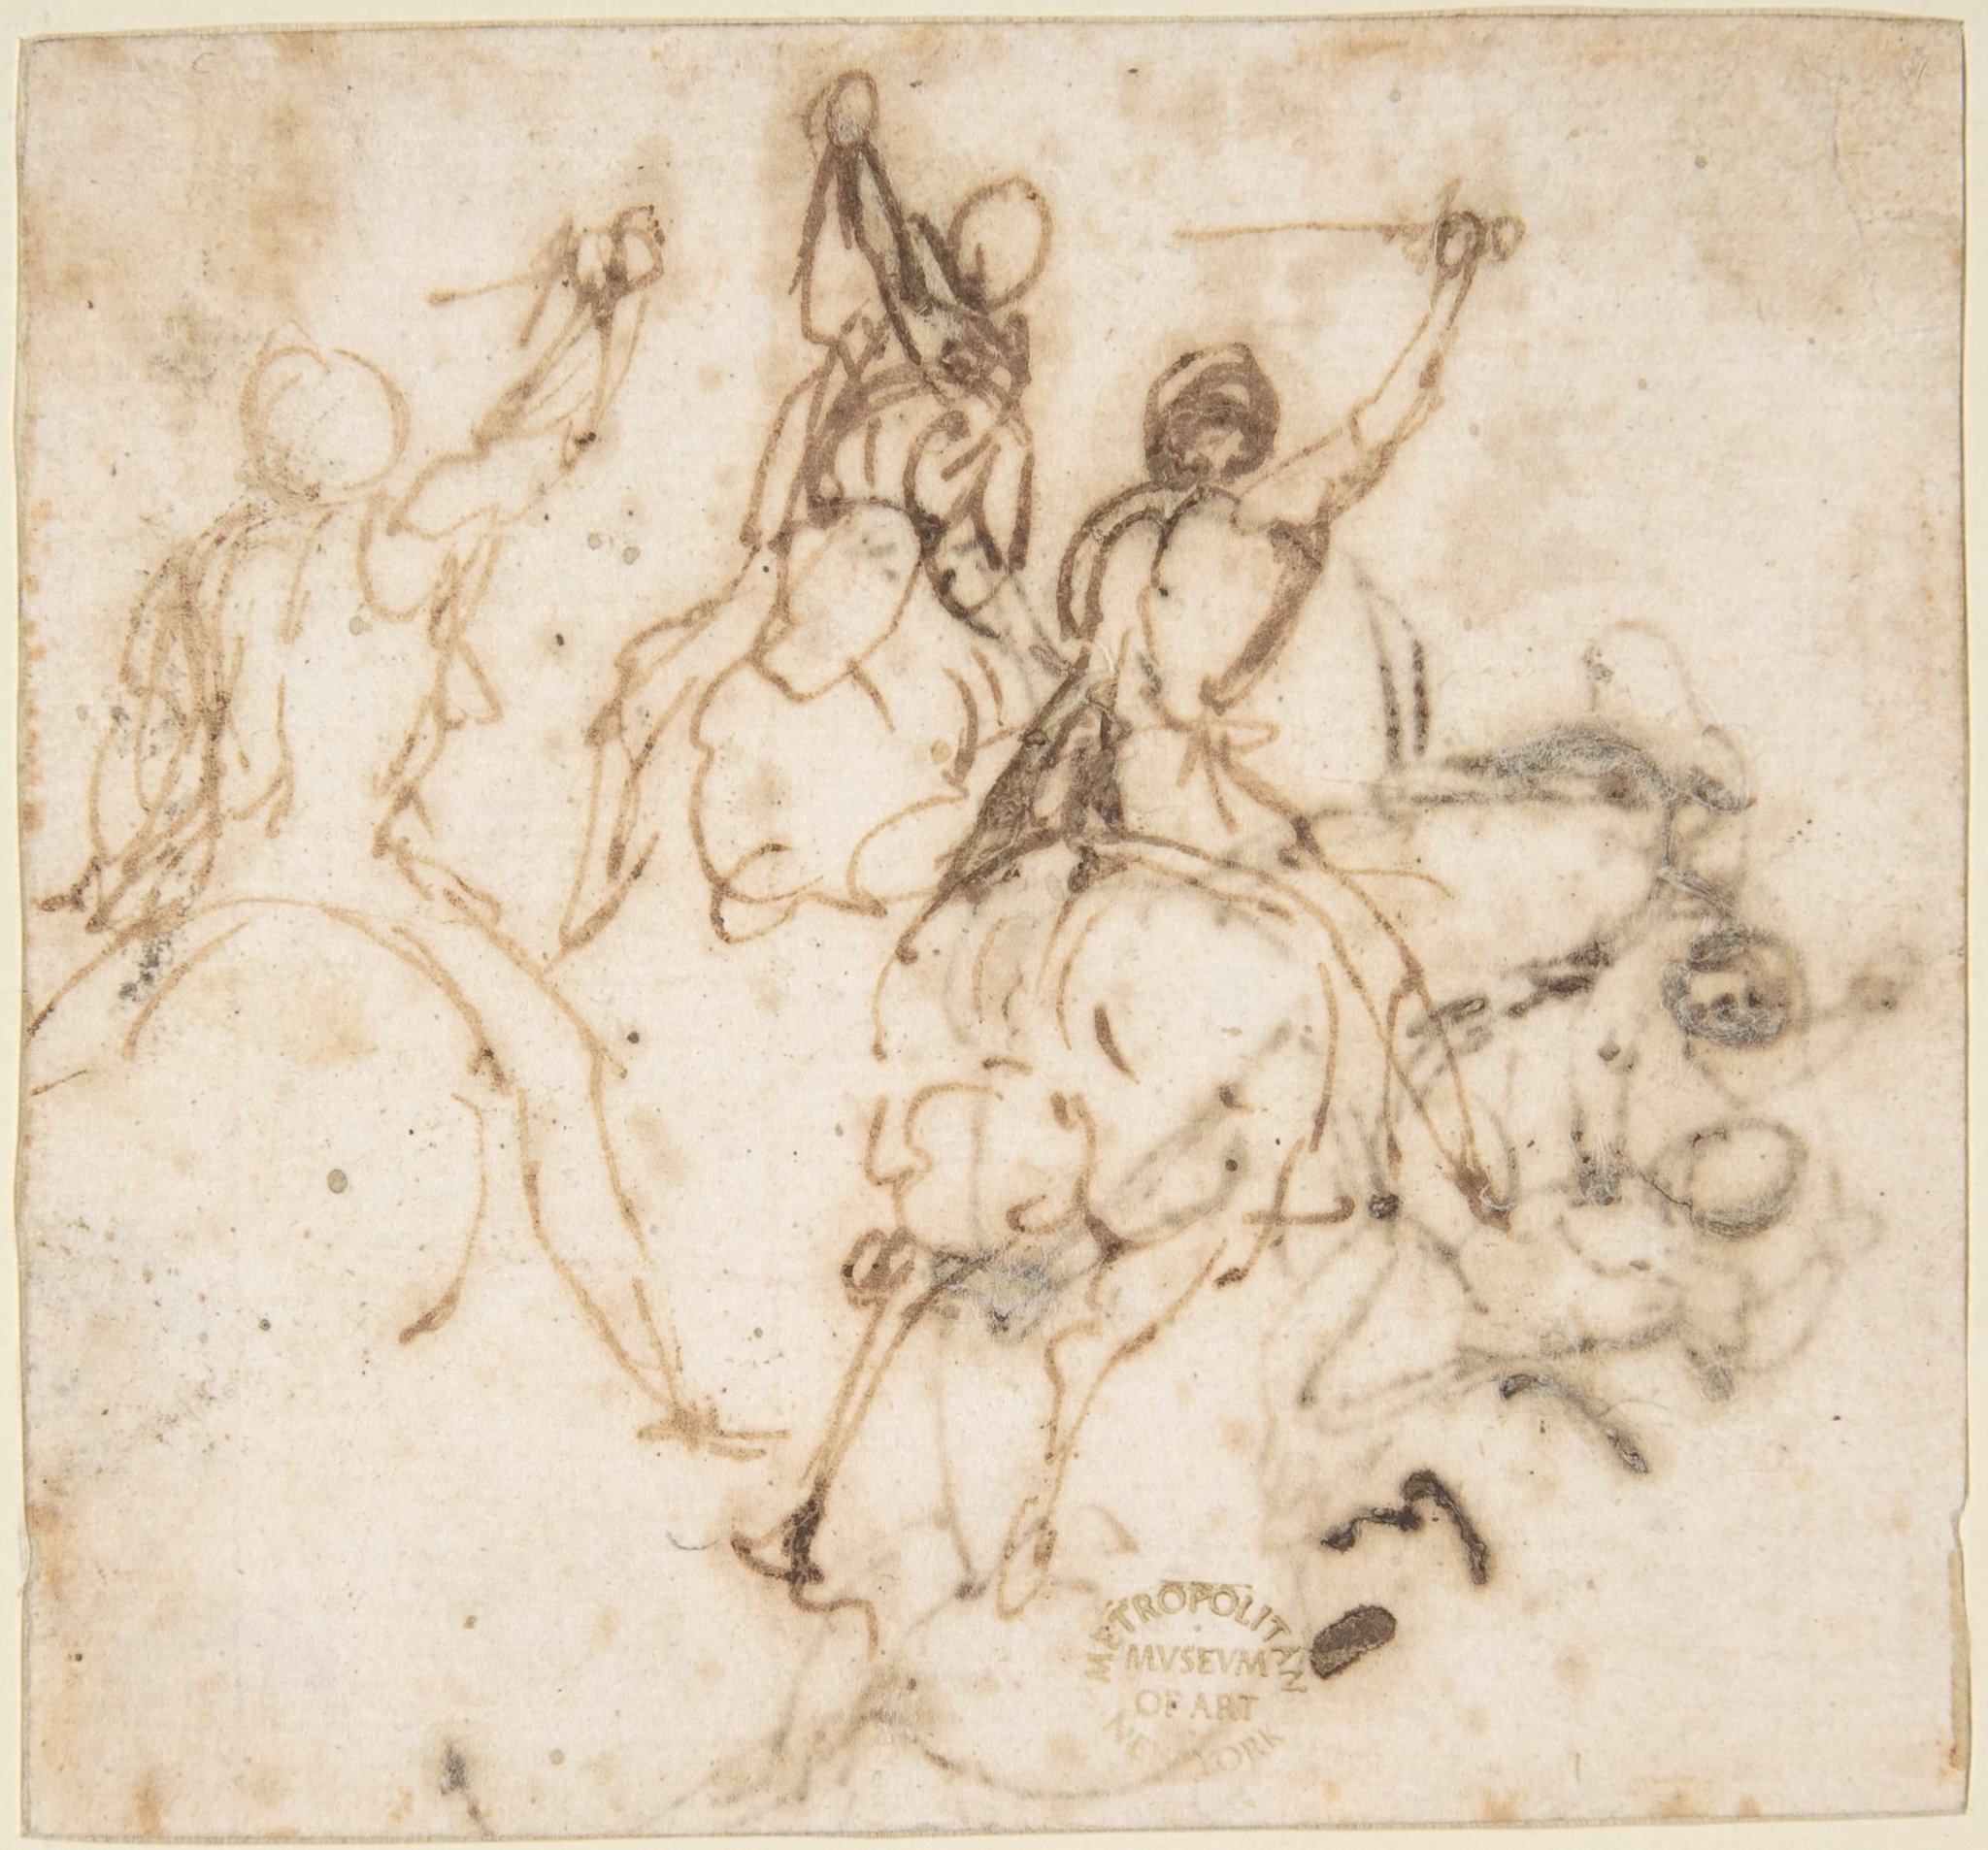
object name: drawing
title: Cavalry Charge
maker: francesco allegrini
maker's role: artist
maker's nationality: italian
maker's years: 1615-1679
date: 1624-1663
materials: ink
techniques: pen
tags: men,horses